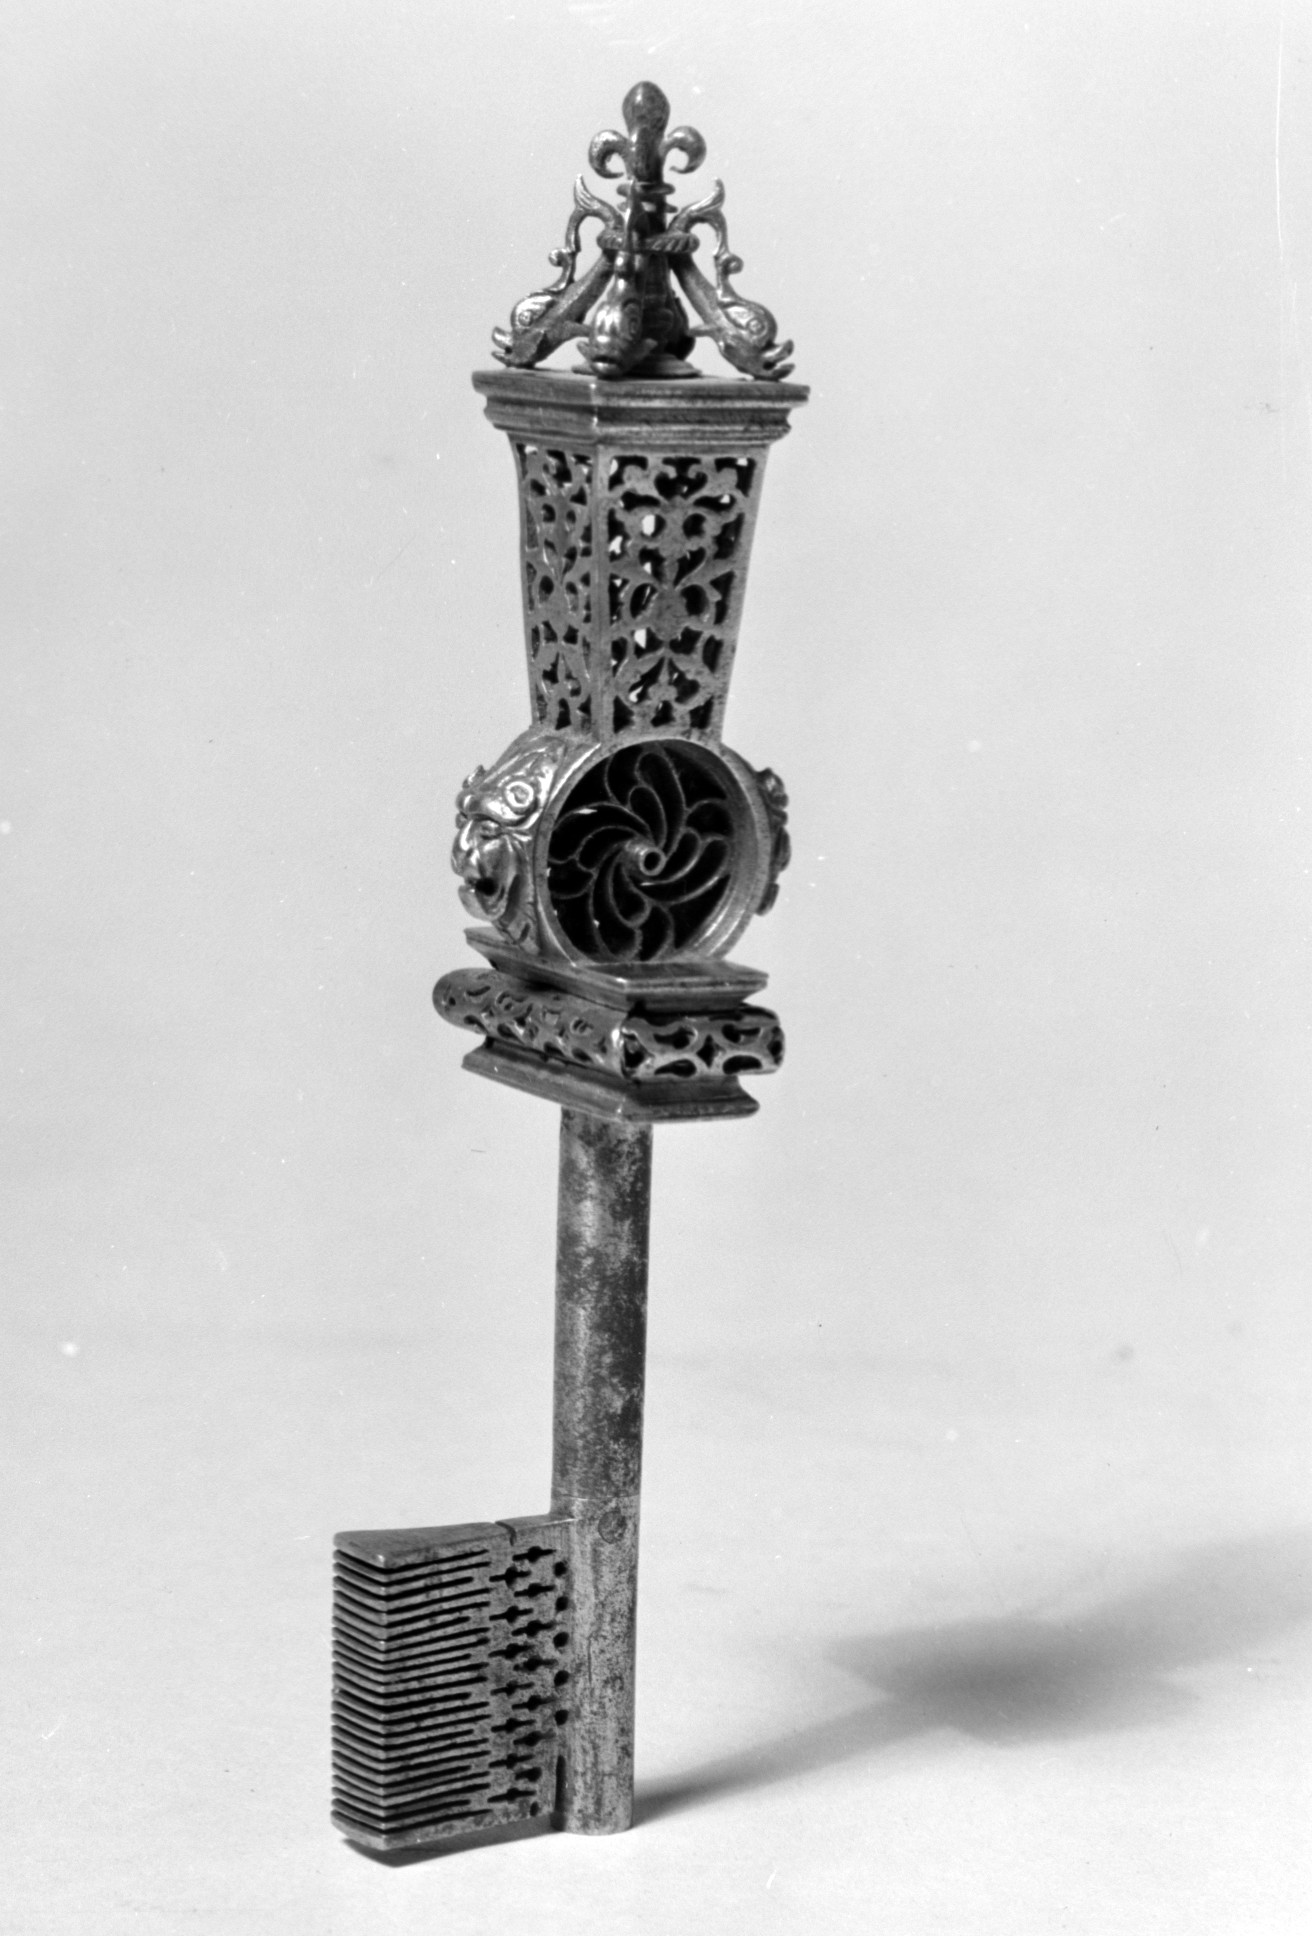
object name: key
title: Masterpiece key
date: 1601-1700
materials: iron, steel